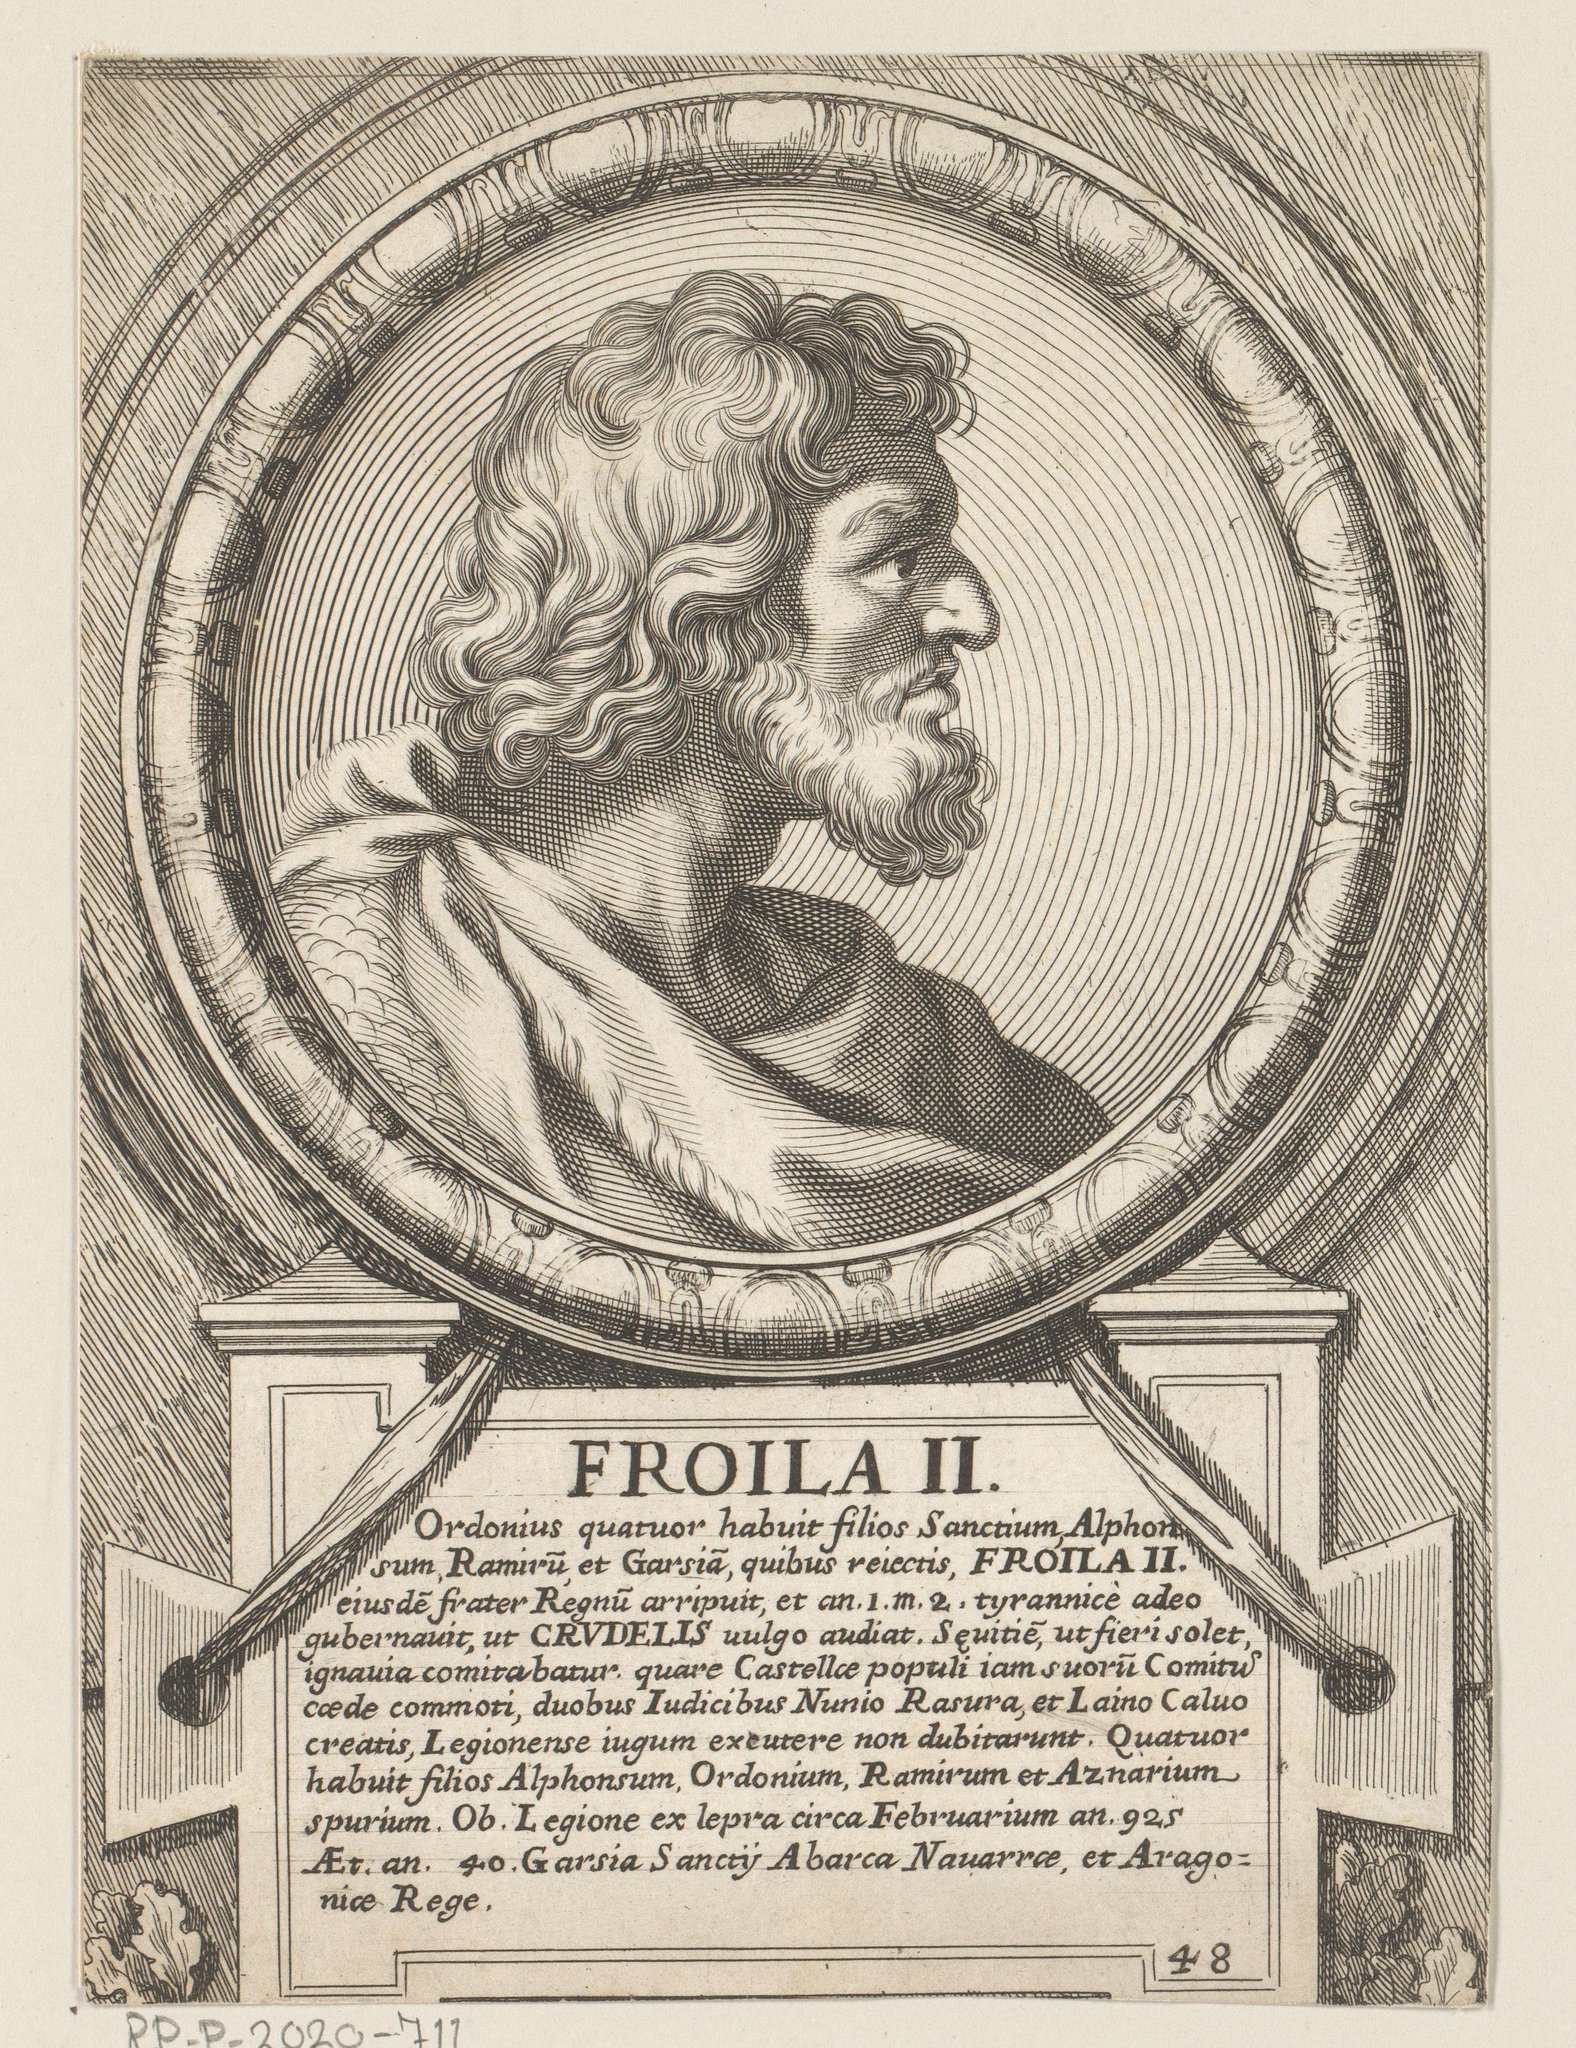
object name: print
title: Portret van Fruela II, koning van Asturië en León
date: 1685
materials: paper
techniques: engraving, etching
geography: rome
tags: historical persons, ruler, sovereign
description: Portret afkomstig van een grote prent, getiteld 'Series Chronologica et Imagines Regu Hispaniae ab Ataulpho ad Carolum II', bestaande uit tien bladen die samengevoegd konden worden, uitgegeven door Giovanni Giacomo de' Rossi in 1685.